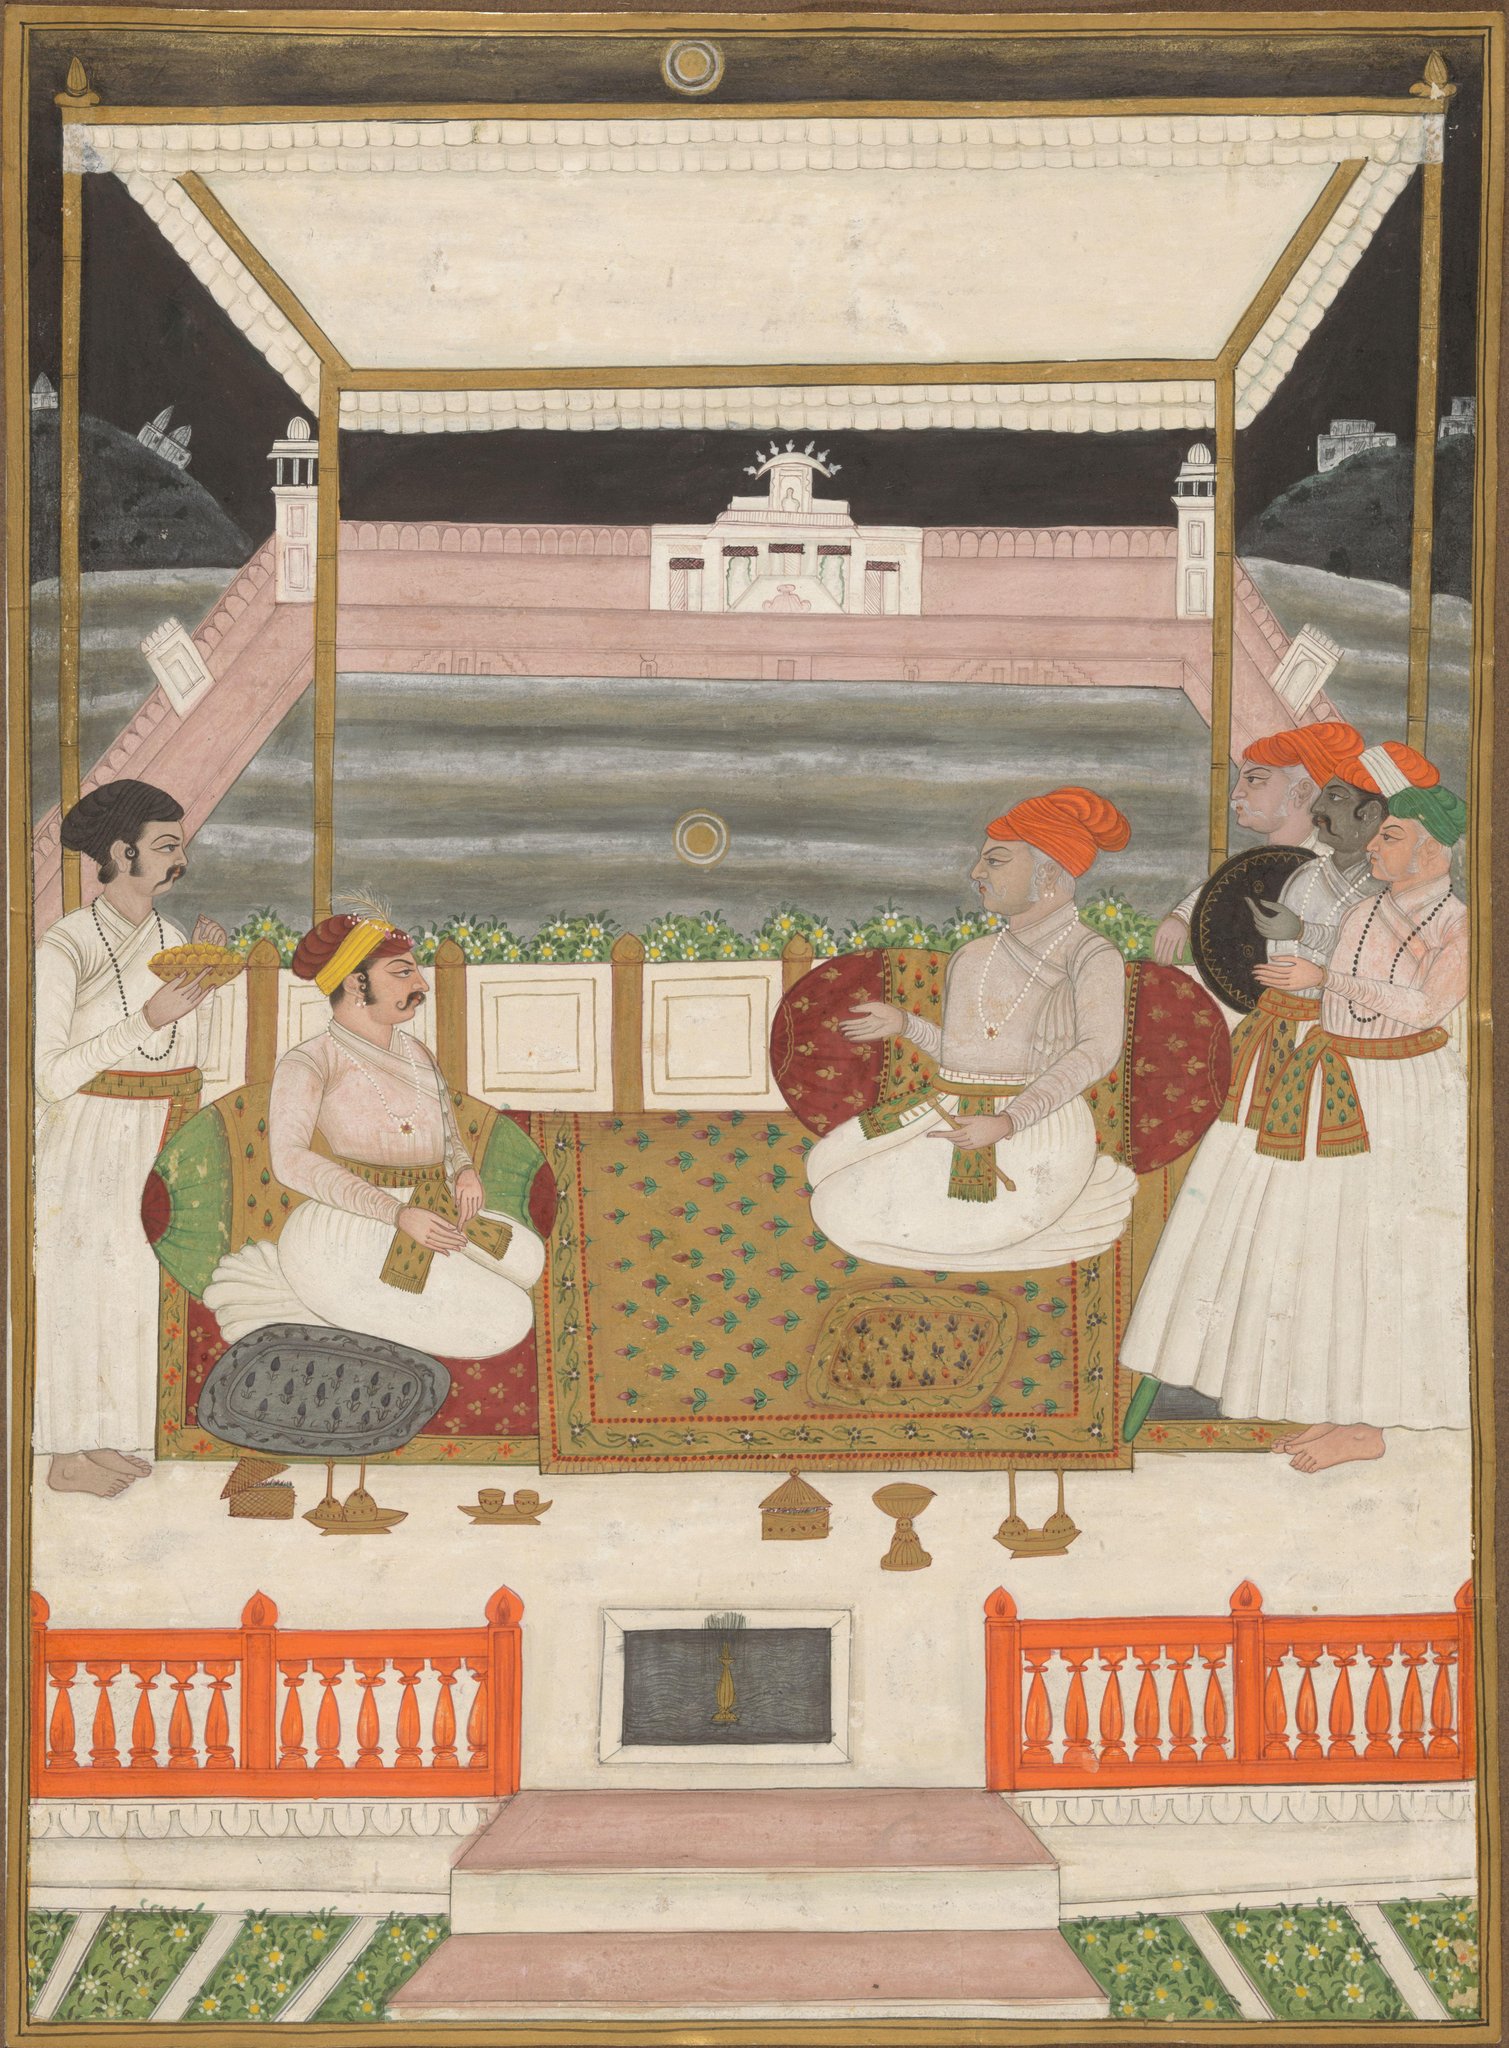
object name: drawing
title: Twee vorsten op een terras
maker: Anonymous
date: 1900-1993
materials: paper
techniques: brush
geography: mewar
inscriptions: inscription: ‘.’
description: Op een wit terras onder een witte baldakijn zitten twee in het wit geklede vorsten tegenover elkaar op een goudkleurig en een donkerrood tapijt, achter de linkervorst een dienaar, ook in wit, achter de rechtervorst drie dienaren, waarvan de voorste een witte rok aan heeft, op de voorgrond schalen en karaffen en tussen de twee oranjerode hekjes van het terras een minuscuul vijvertje met een fonteintje, roze-witte traptreden leiden naar een tuin met bloemperken; op de achtergrond een roze ommuurde binnenplaats en een wit poortgebouw, daarachter de donkere heuvels van de stad met enkele gebouwen tegen een donkere nachthemel. Rond de voorstelling een goudkleurig biesje met zwarte kaderlijnen.